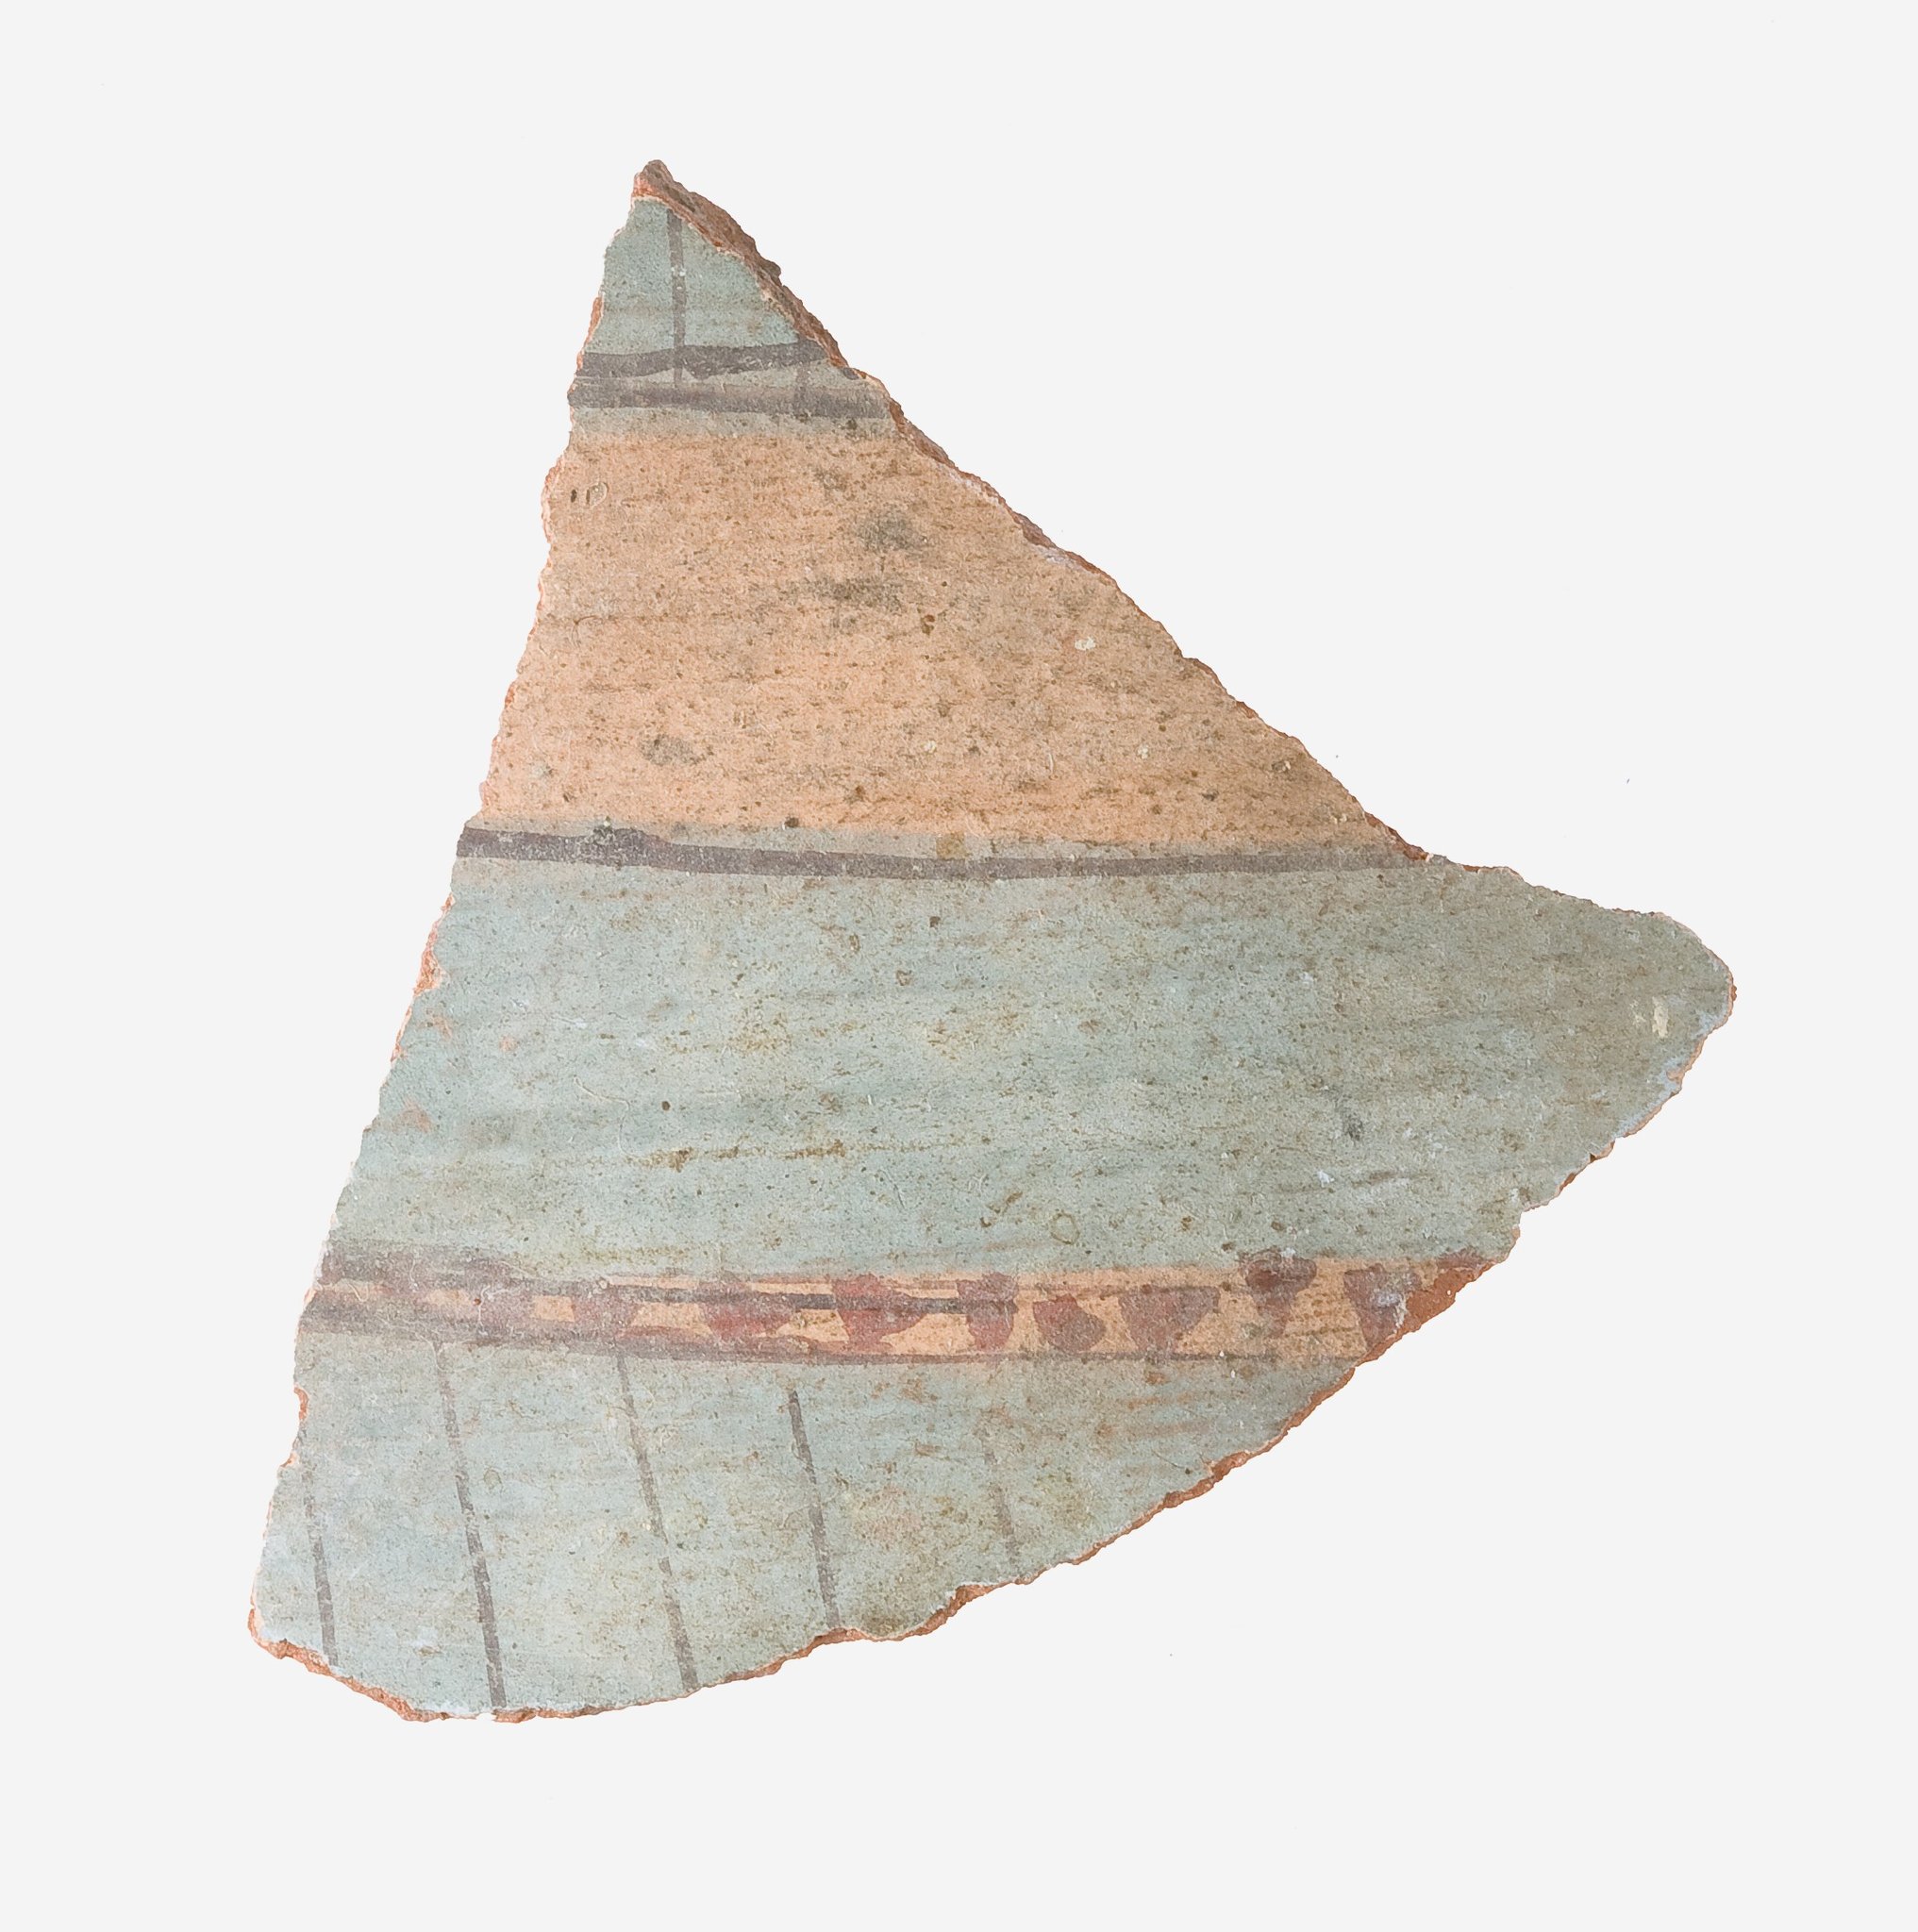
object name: vessel fragment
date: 1390-1352 BCE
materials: paint, pottery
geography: egypt